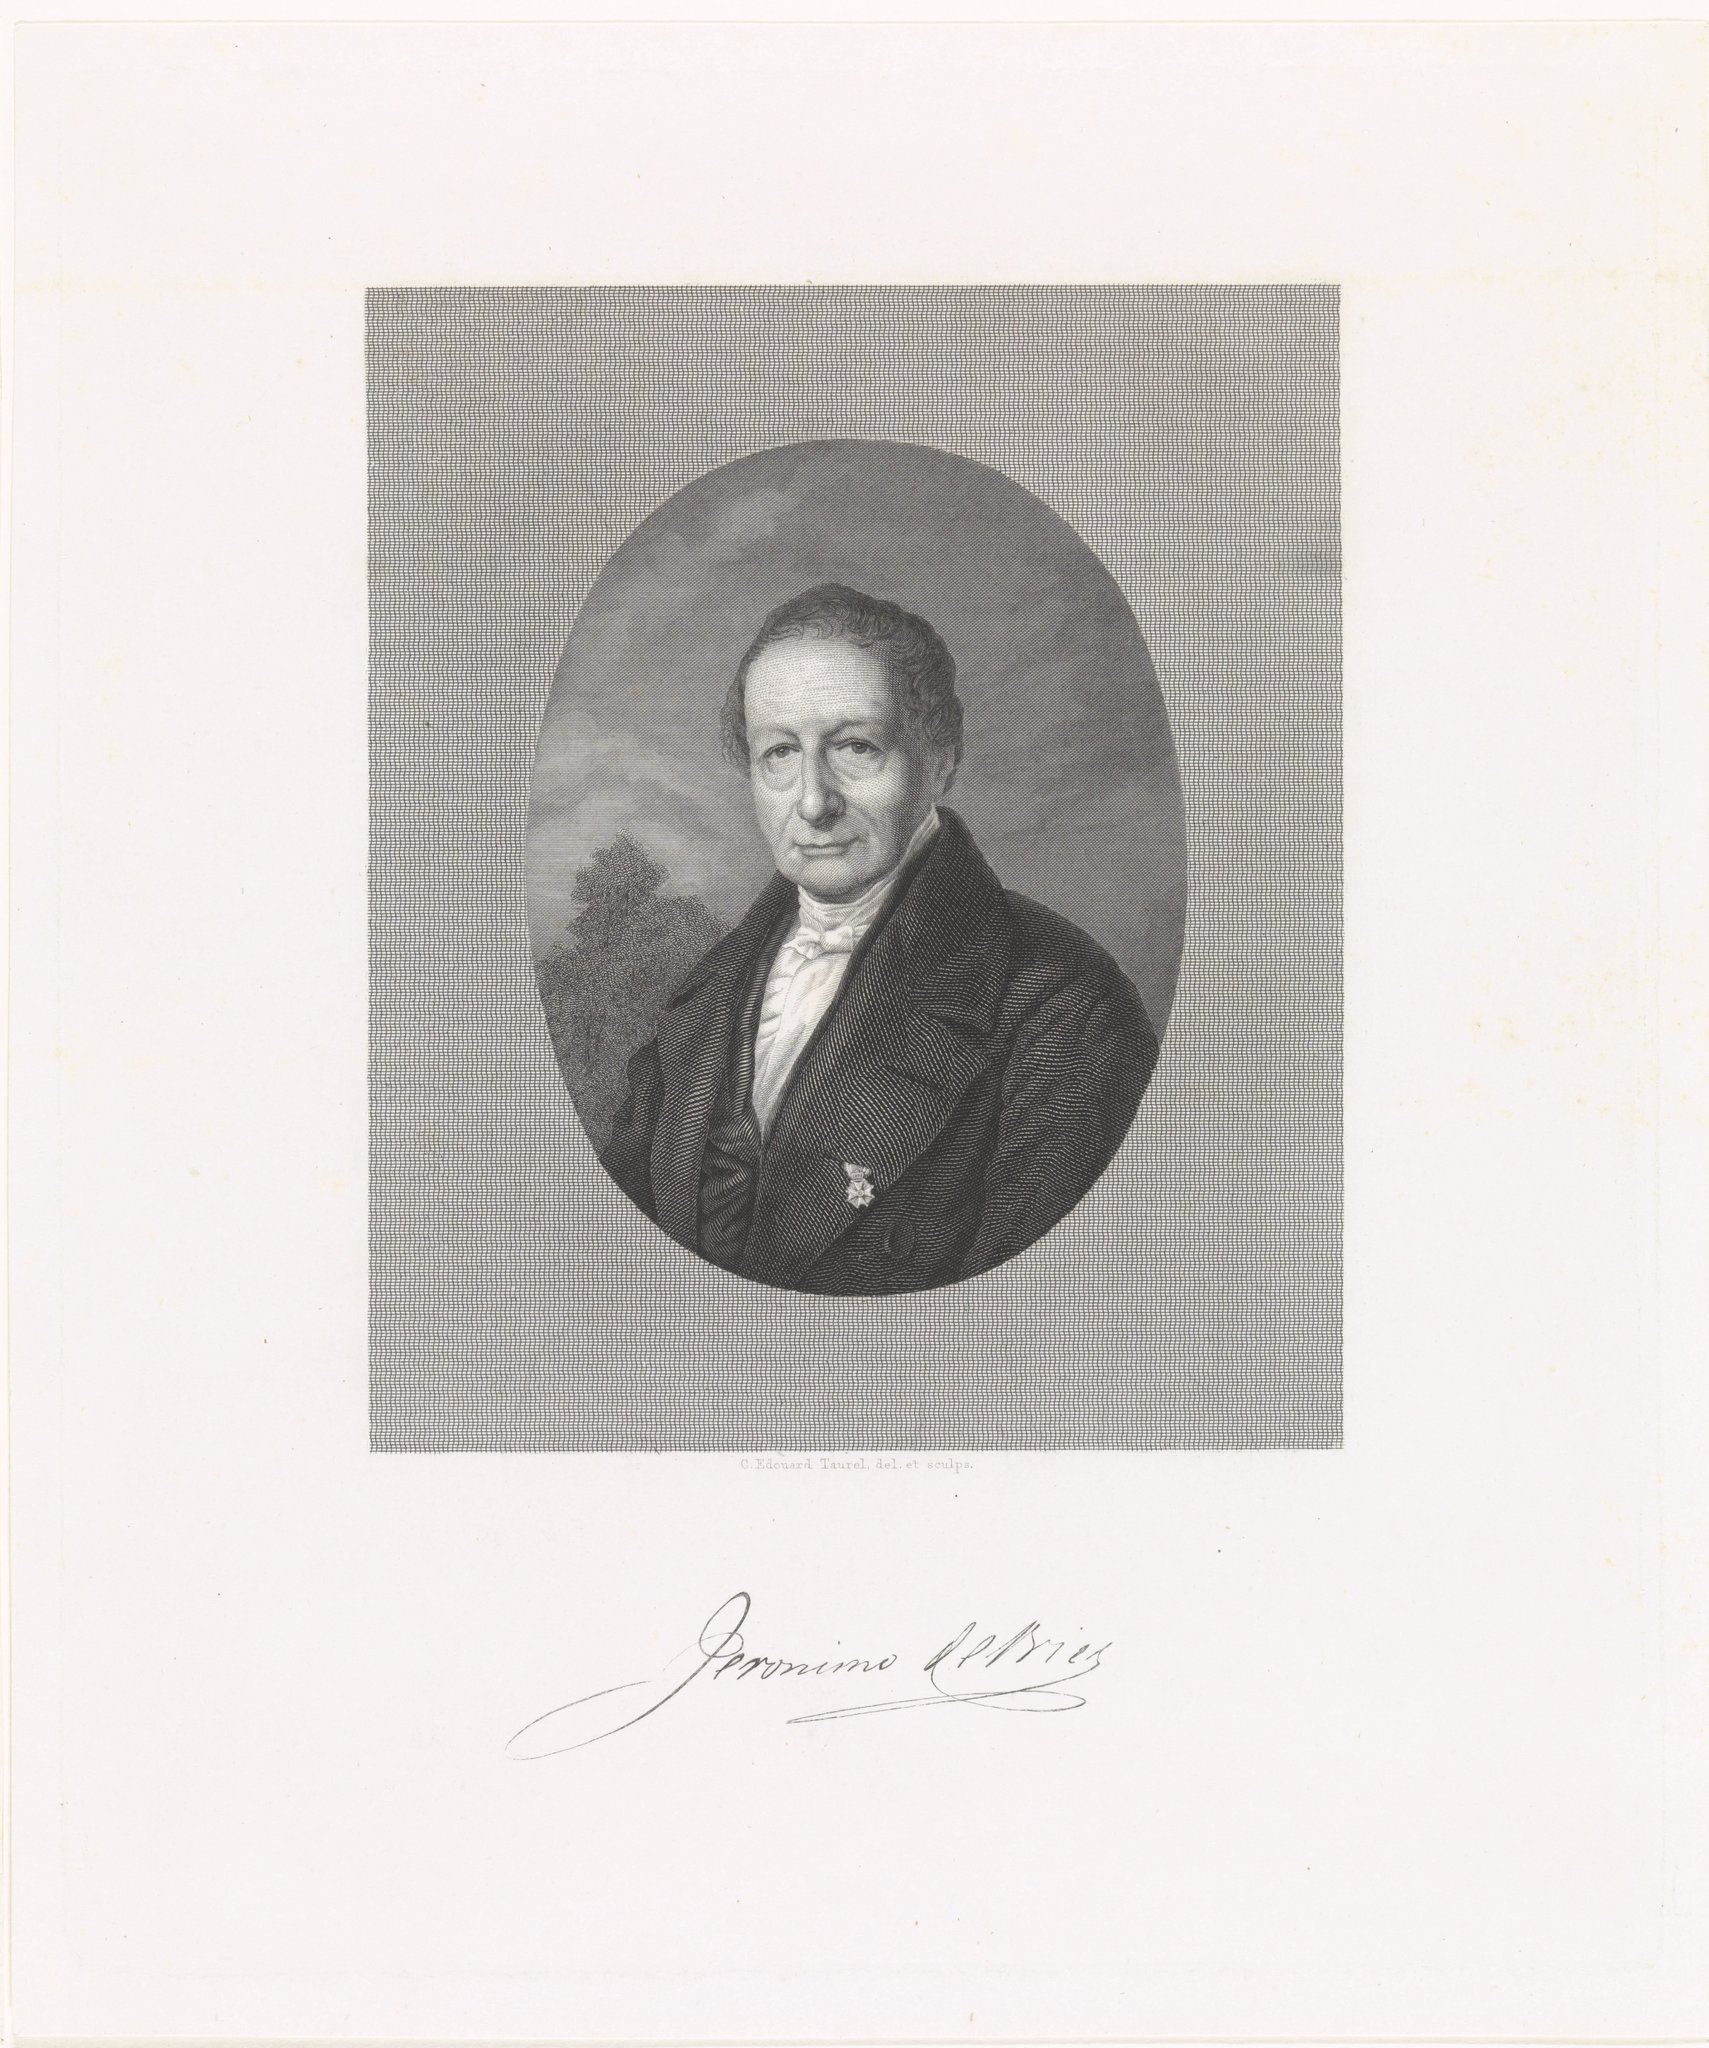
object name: print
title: Portret van Jeronimo de Vries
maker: edouard taurel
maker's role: draughtsman, print maker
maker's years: 1824-1892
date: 1834-1853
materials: paper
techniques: engraving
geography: amsterdam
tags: jeronimo de vries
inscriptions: collector's mark: Lugt 2228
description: Portret van de Amsterdamse stadssecretaris Jeronimo de Vries.